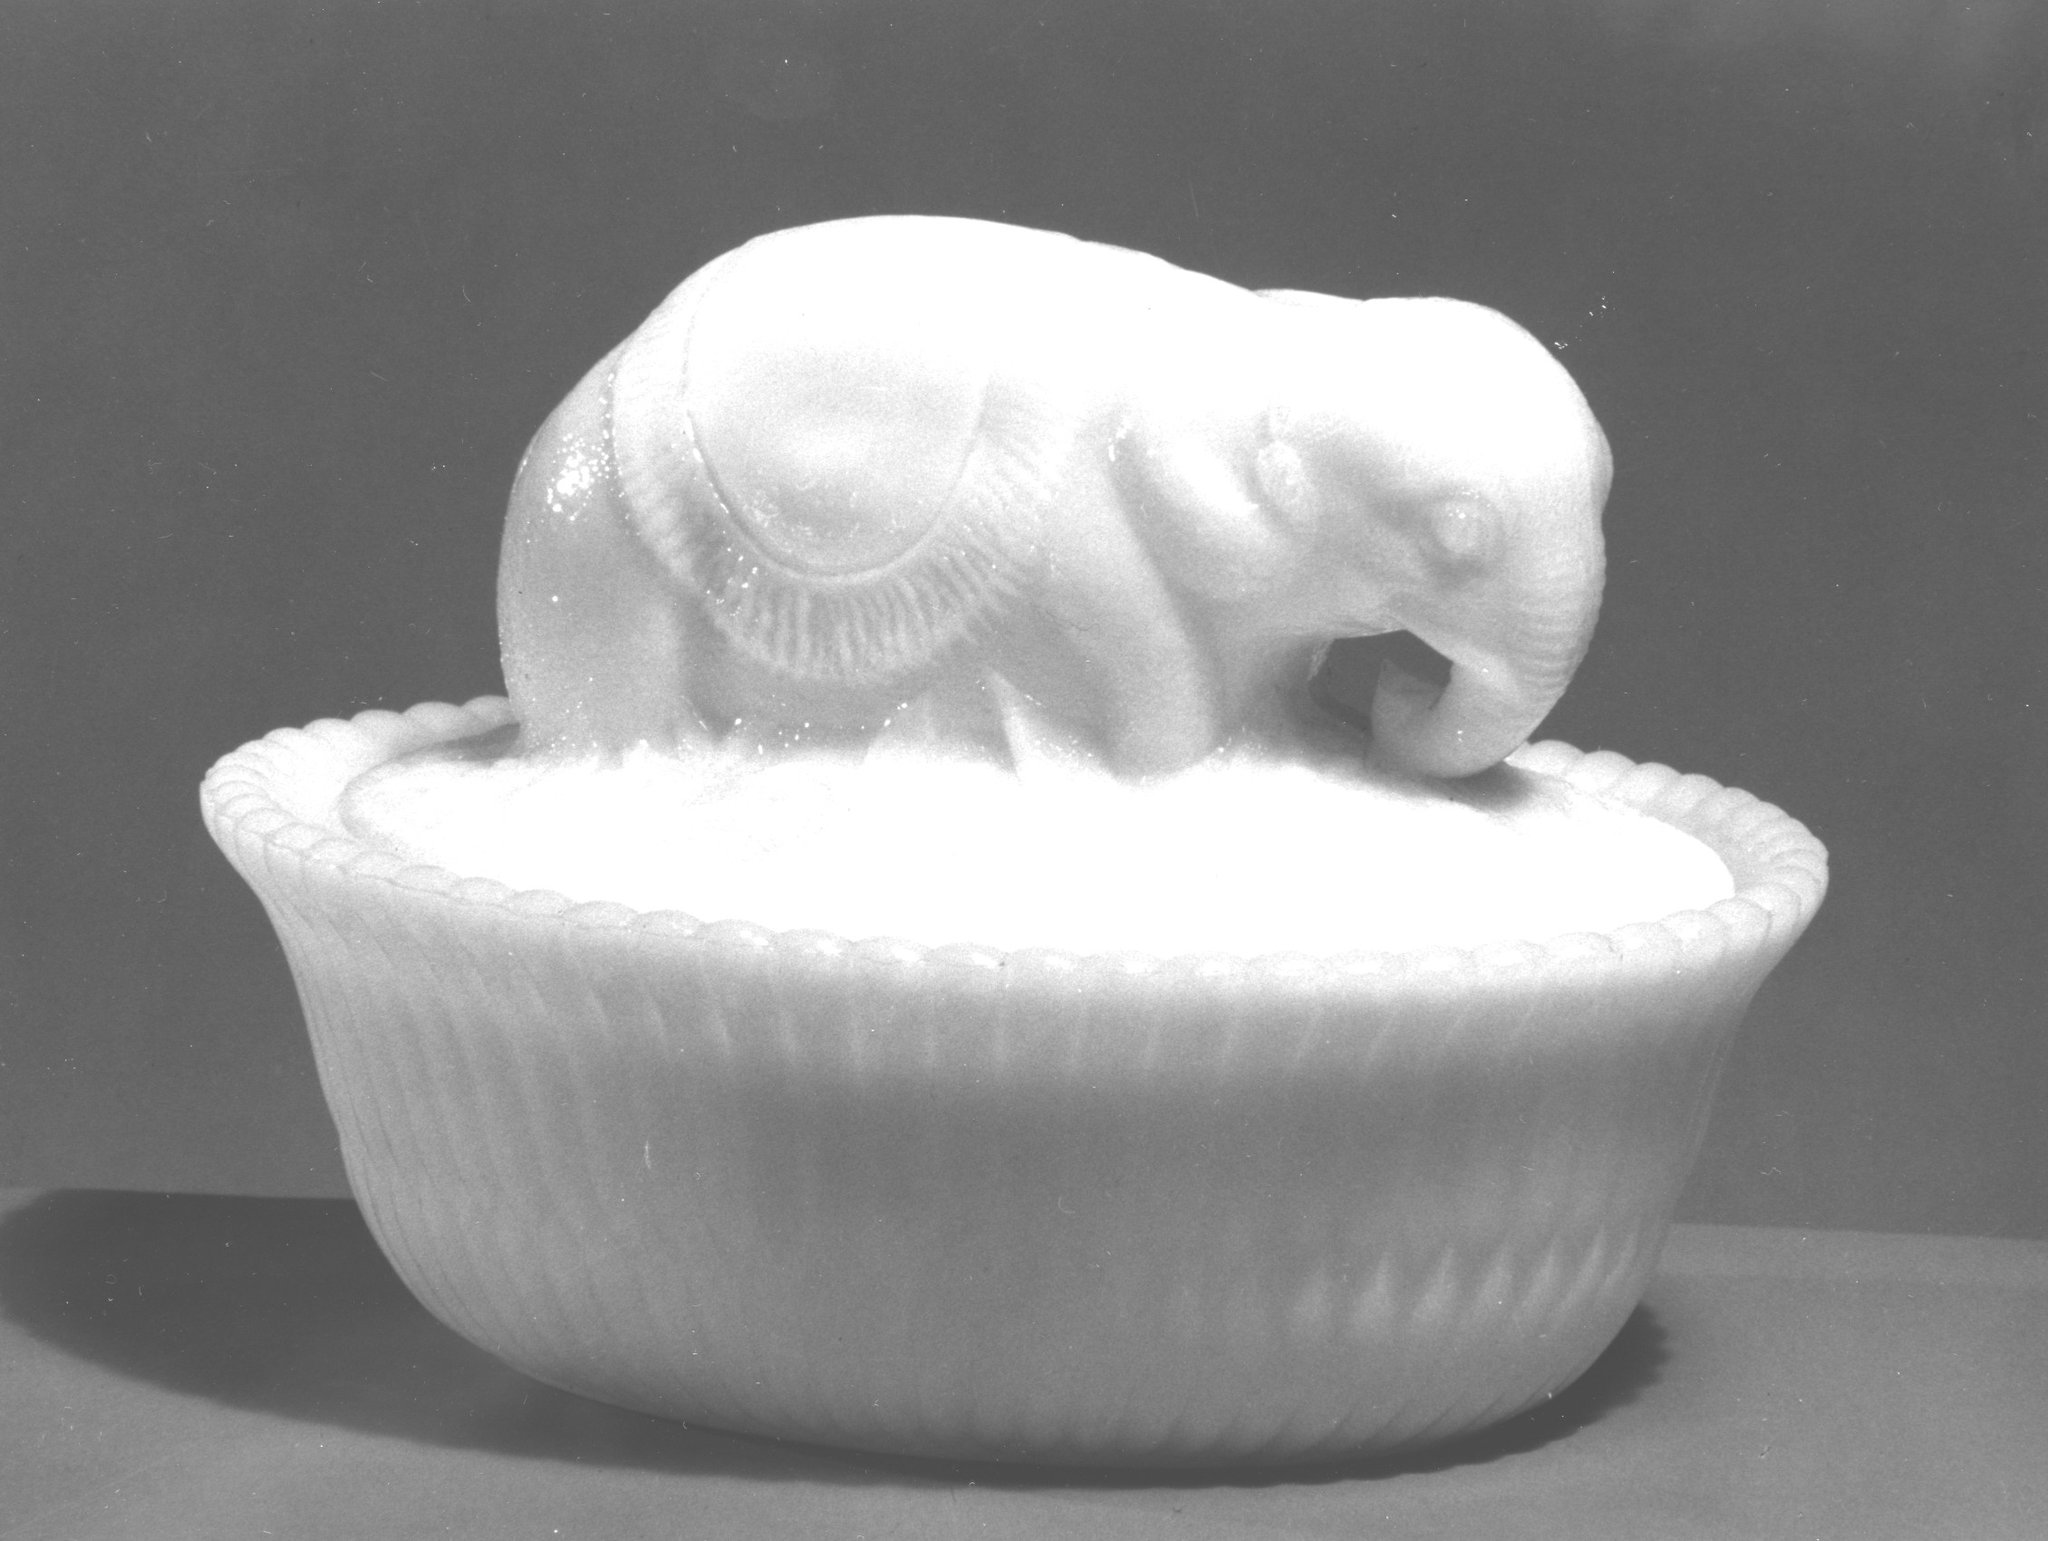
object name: dish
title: Figure Dish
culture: american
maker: mckee and brothers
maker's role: maker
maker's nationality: american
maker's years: 1856-1889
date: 1880-1890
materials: glass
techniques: pressed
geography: united states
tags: elephants